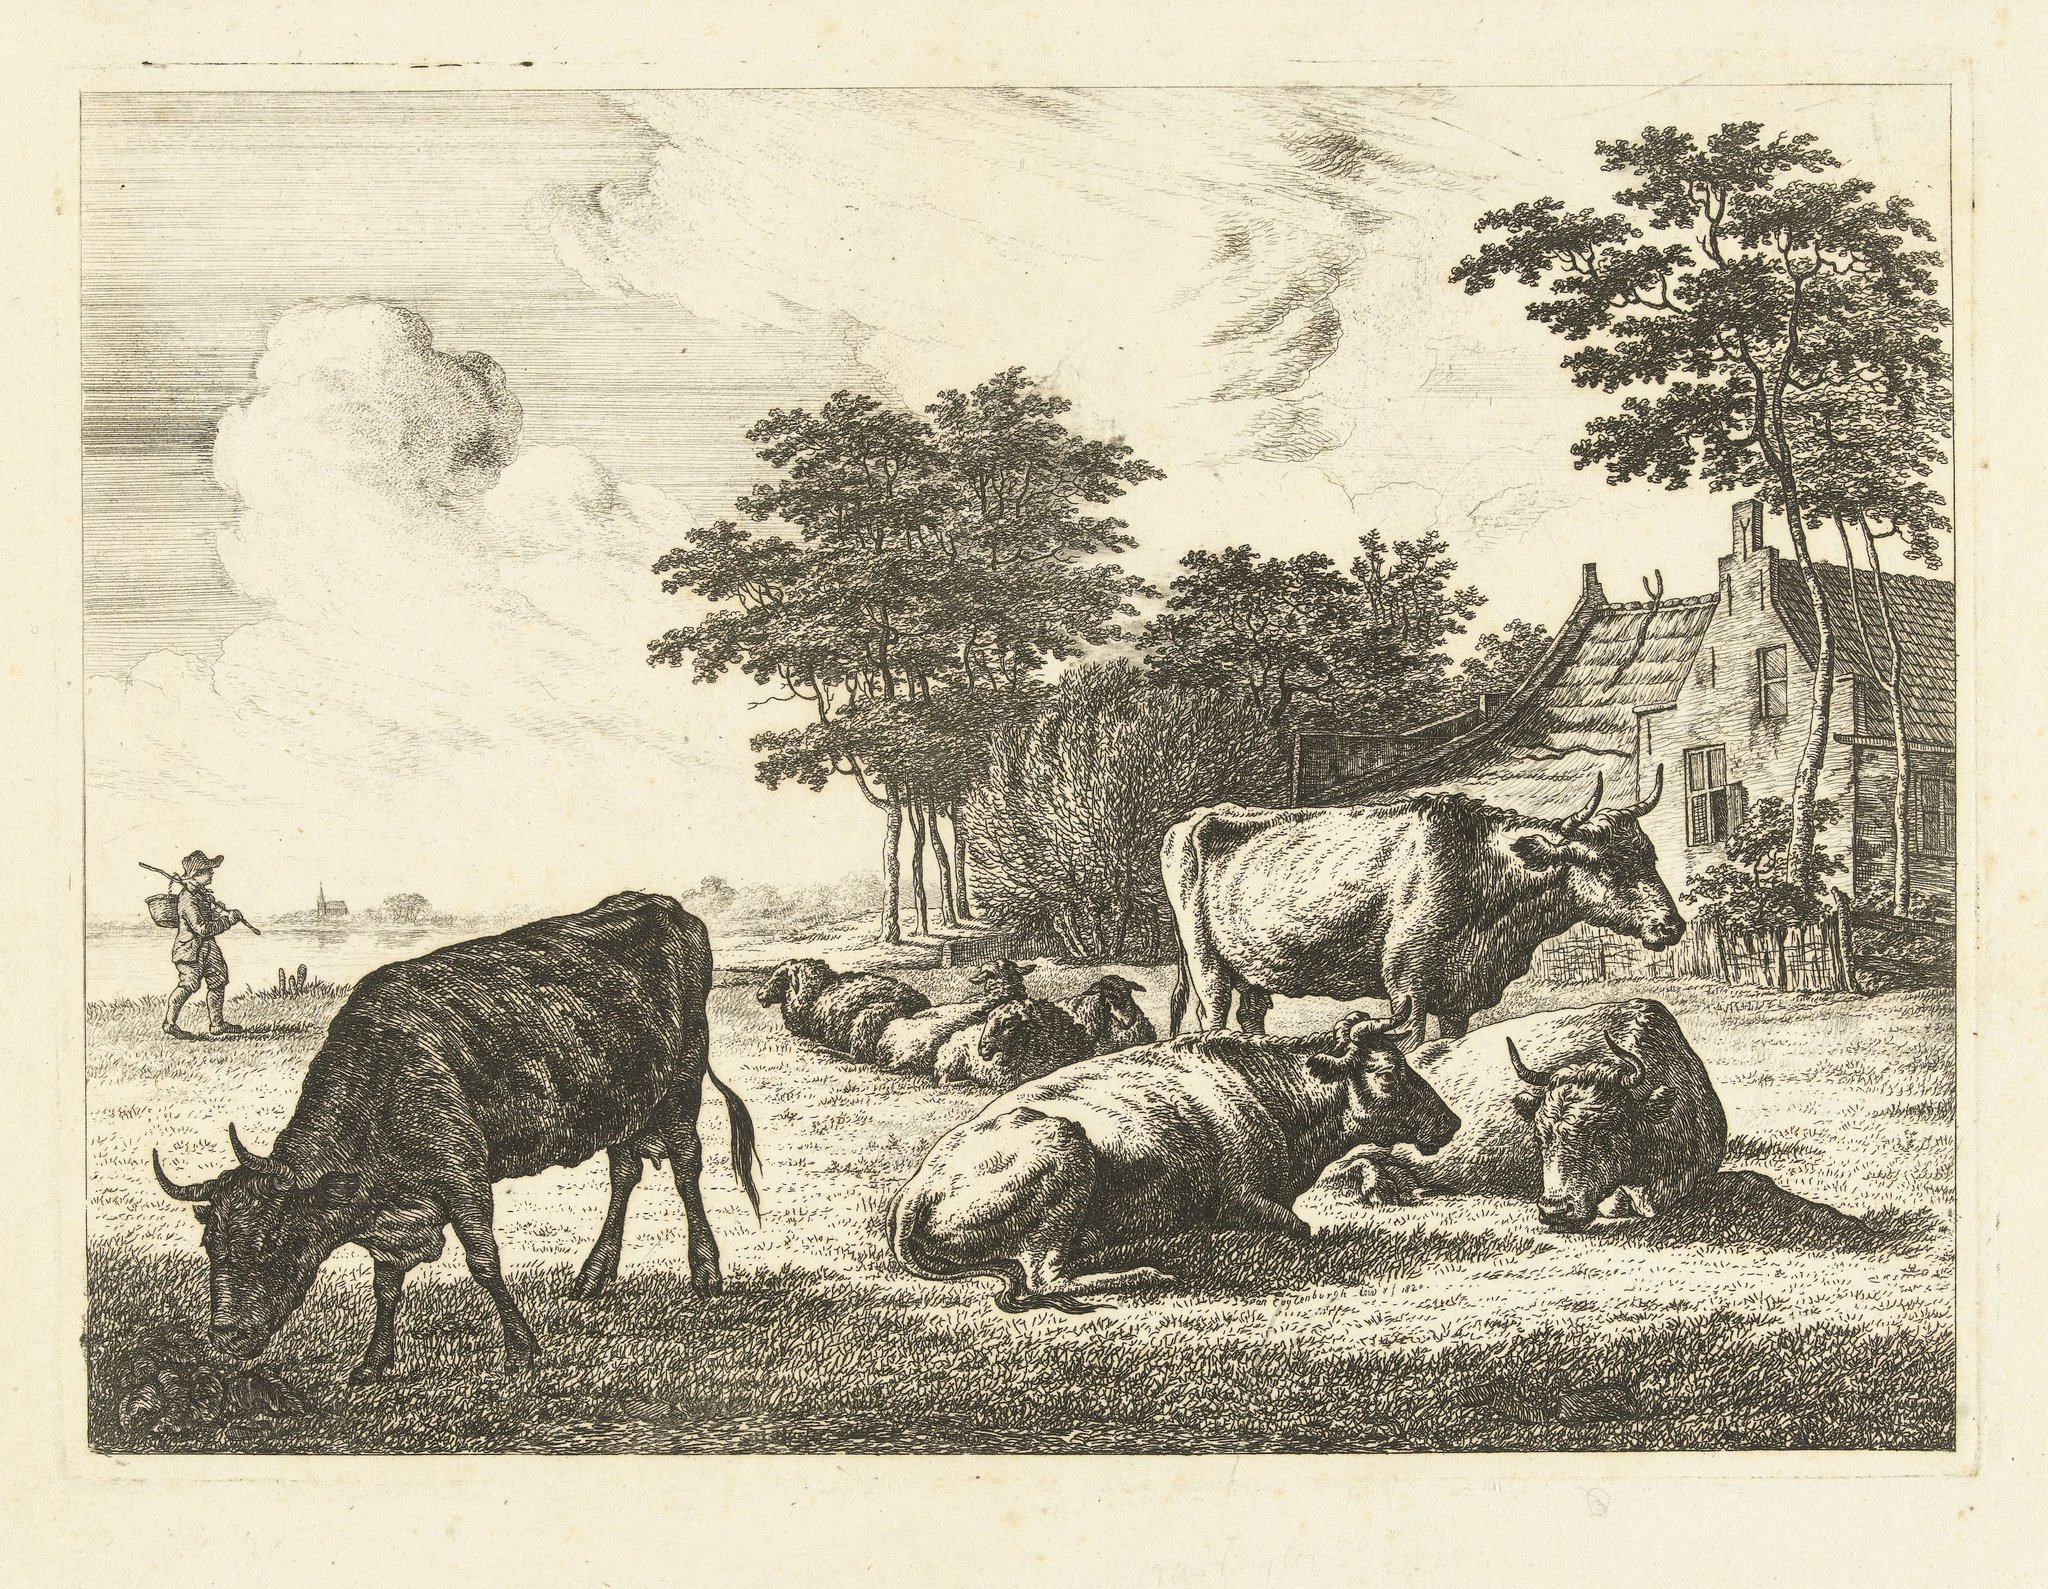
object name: print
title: Koeien en schapen liggend in weide voor boerderij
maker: johannes van cuylenburgh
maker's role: print maker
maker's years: 1793-1841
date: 1820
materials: paper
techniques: etching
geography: netherlands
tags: cow, sheep, farm or solitary house in landscape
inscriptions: collector's mark: Lugt 2228